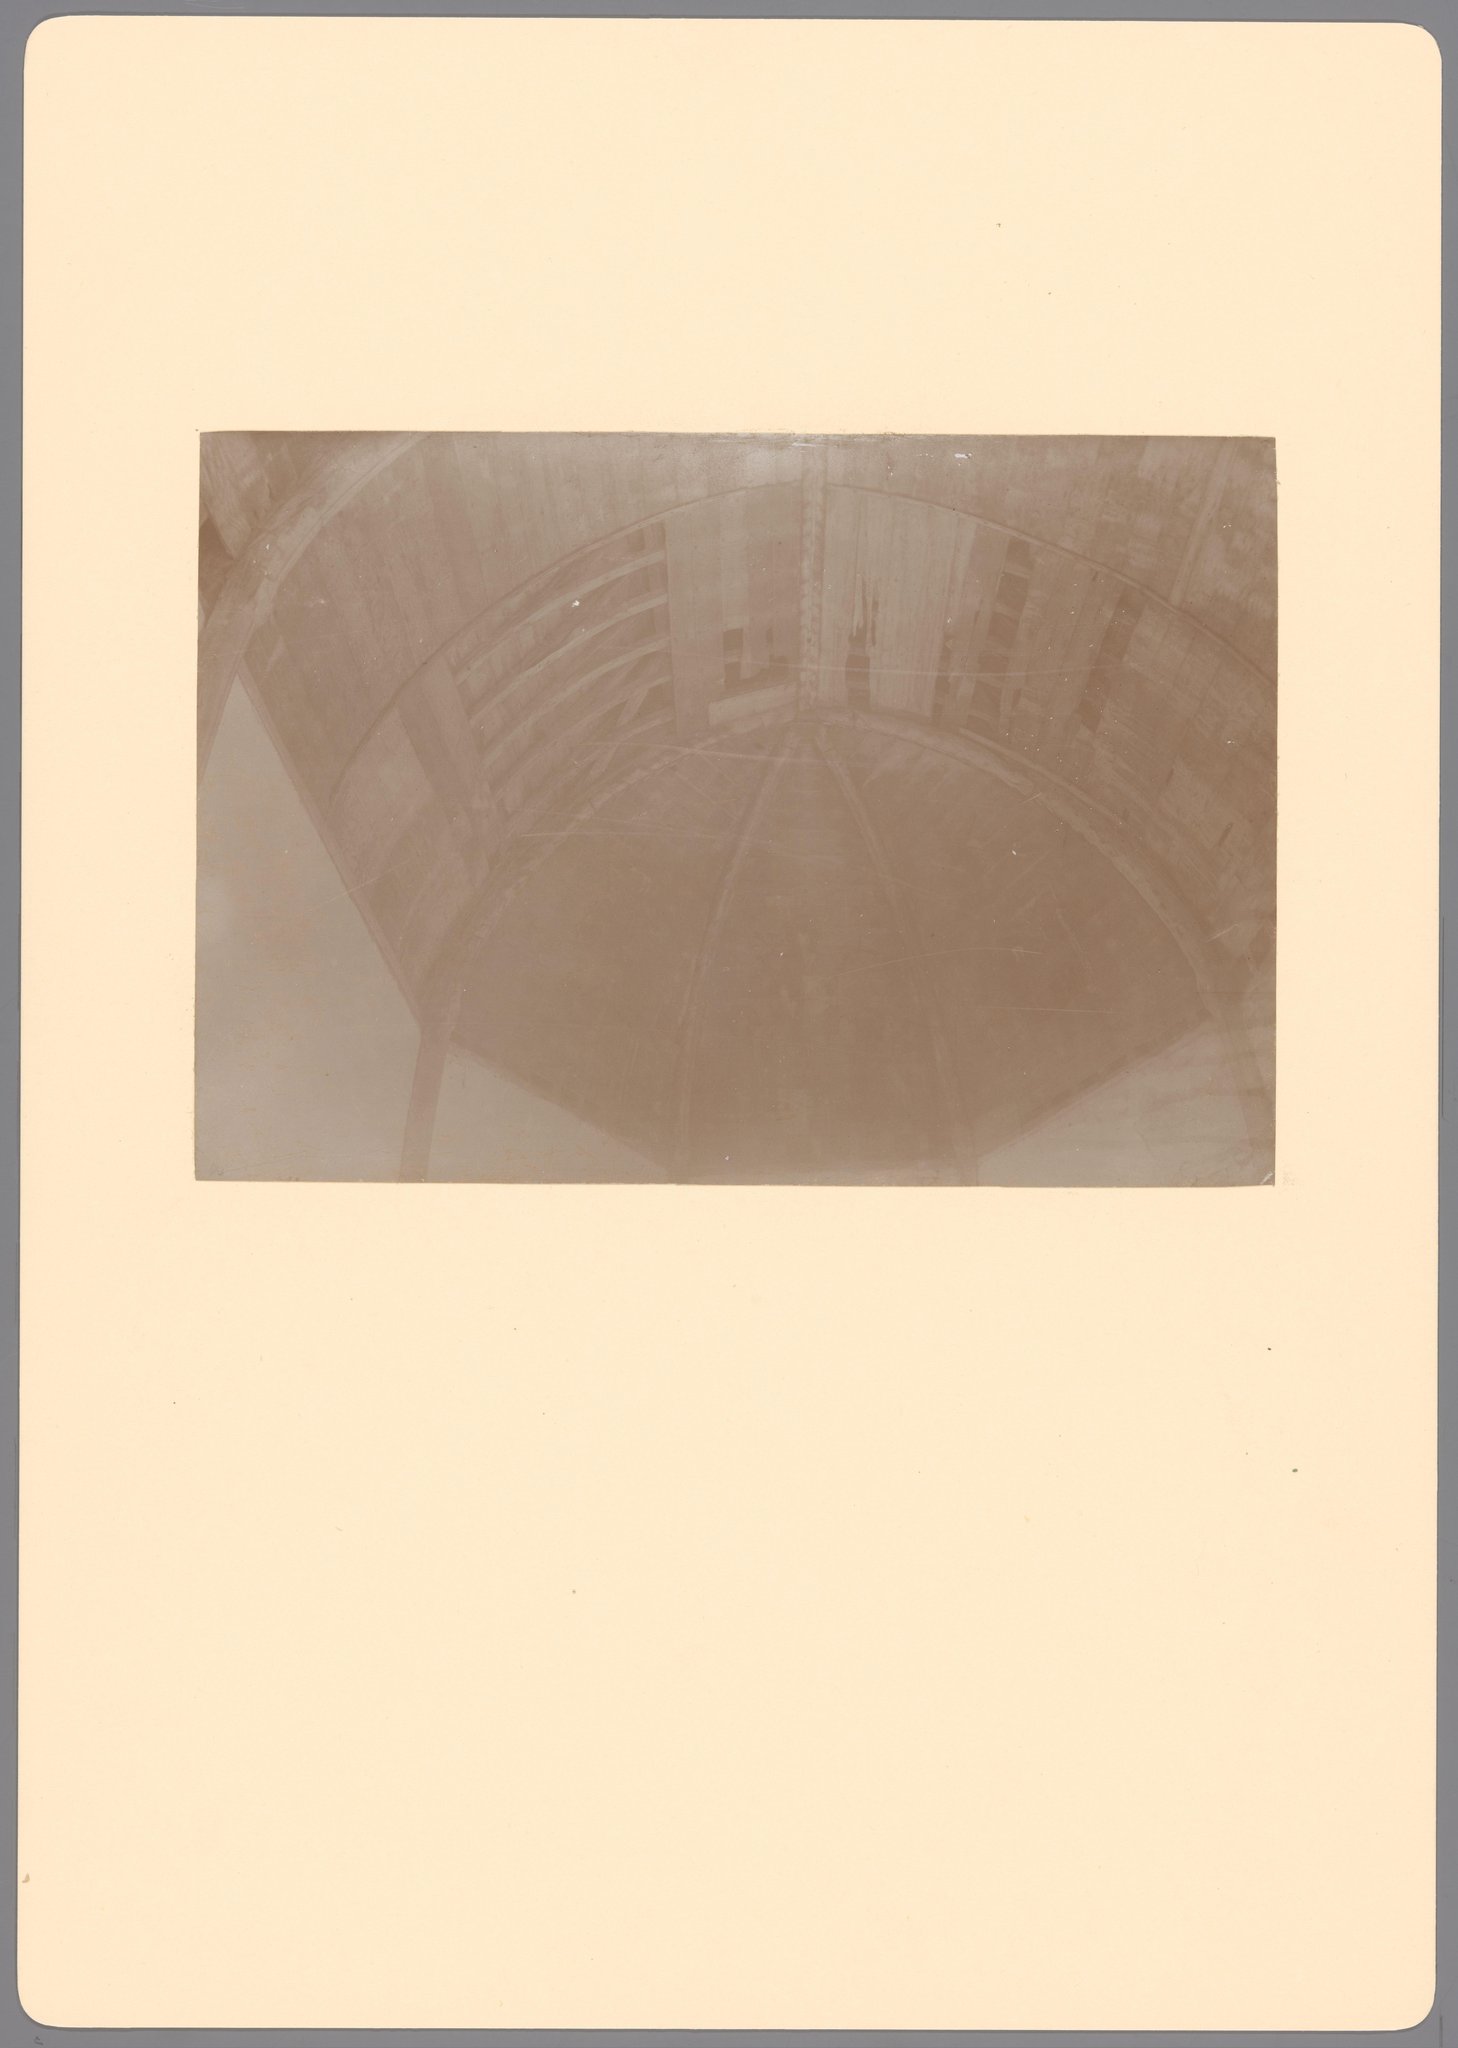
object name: photograph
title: Gewelf in de Hervormde Kerk te Kerkwijk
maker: anoniem (monumentenzorg)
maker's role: fotograaf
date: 1890-1920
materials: cardboard, photographic support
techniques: collodion silver print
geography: kerkwijk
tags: interior of church, dome ~ architecture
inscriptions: annotation: ‘Kerkwijk Gelderland/ geschilderd gewelf in de kerk der N.H. gemeente’